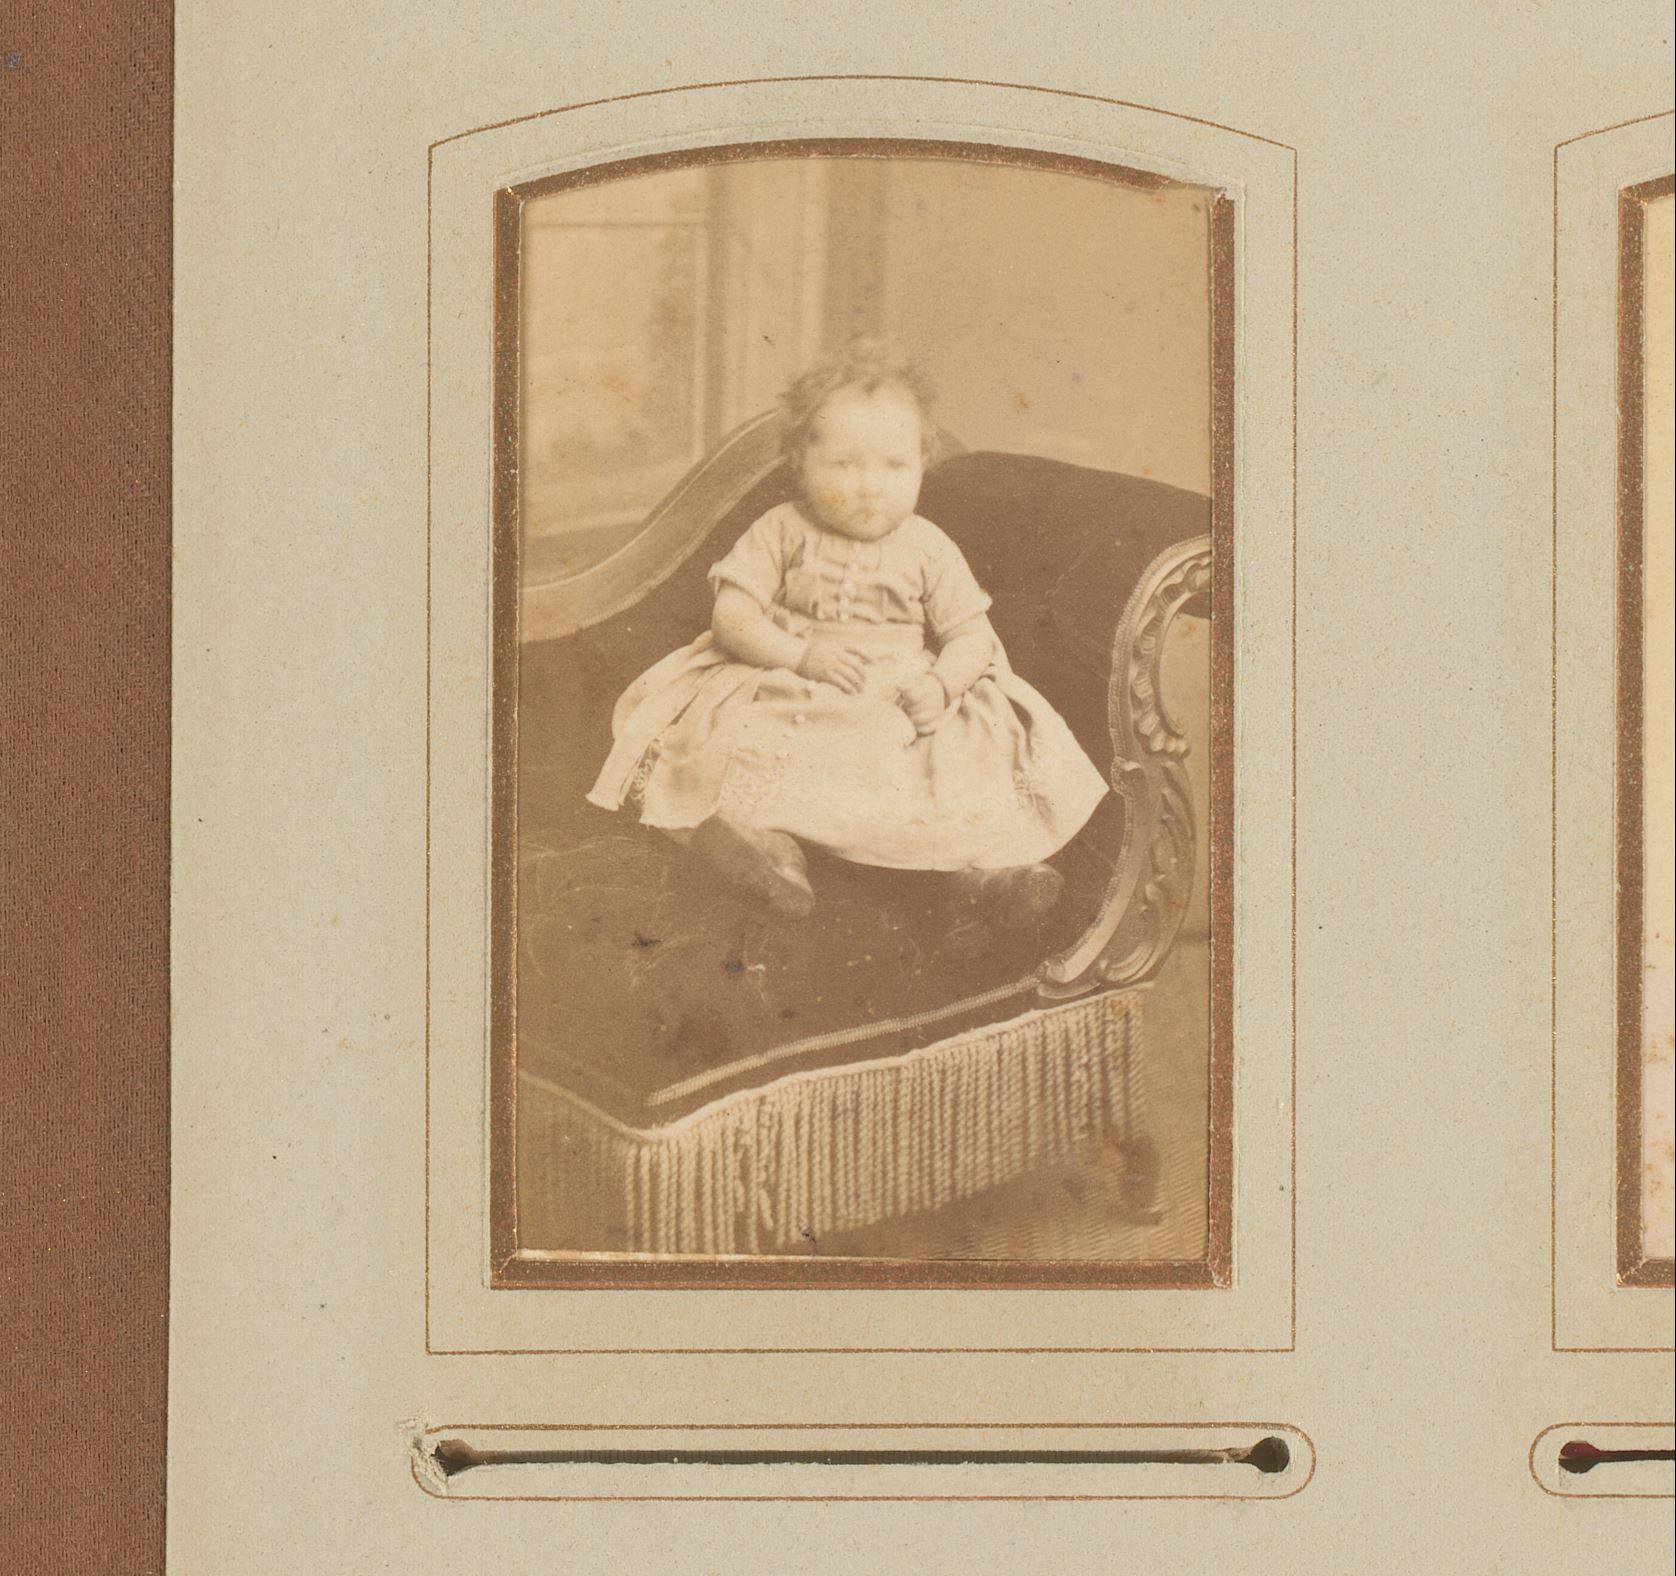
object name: photograph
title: Portret van een zittend kind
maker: albert greiner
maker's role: fotograaf, fotostudio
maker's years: 1833-1890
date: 1861-1887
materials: cardboard, photographic support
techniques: albumen print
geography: amsterdam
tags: sitting figure, historical persons, tot, toddler ~ the ages of man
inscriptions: inscription: ‘A. GREINER/ Photograf/ AMSTERDAM/ NIEUWENDIJK L. 89’